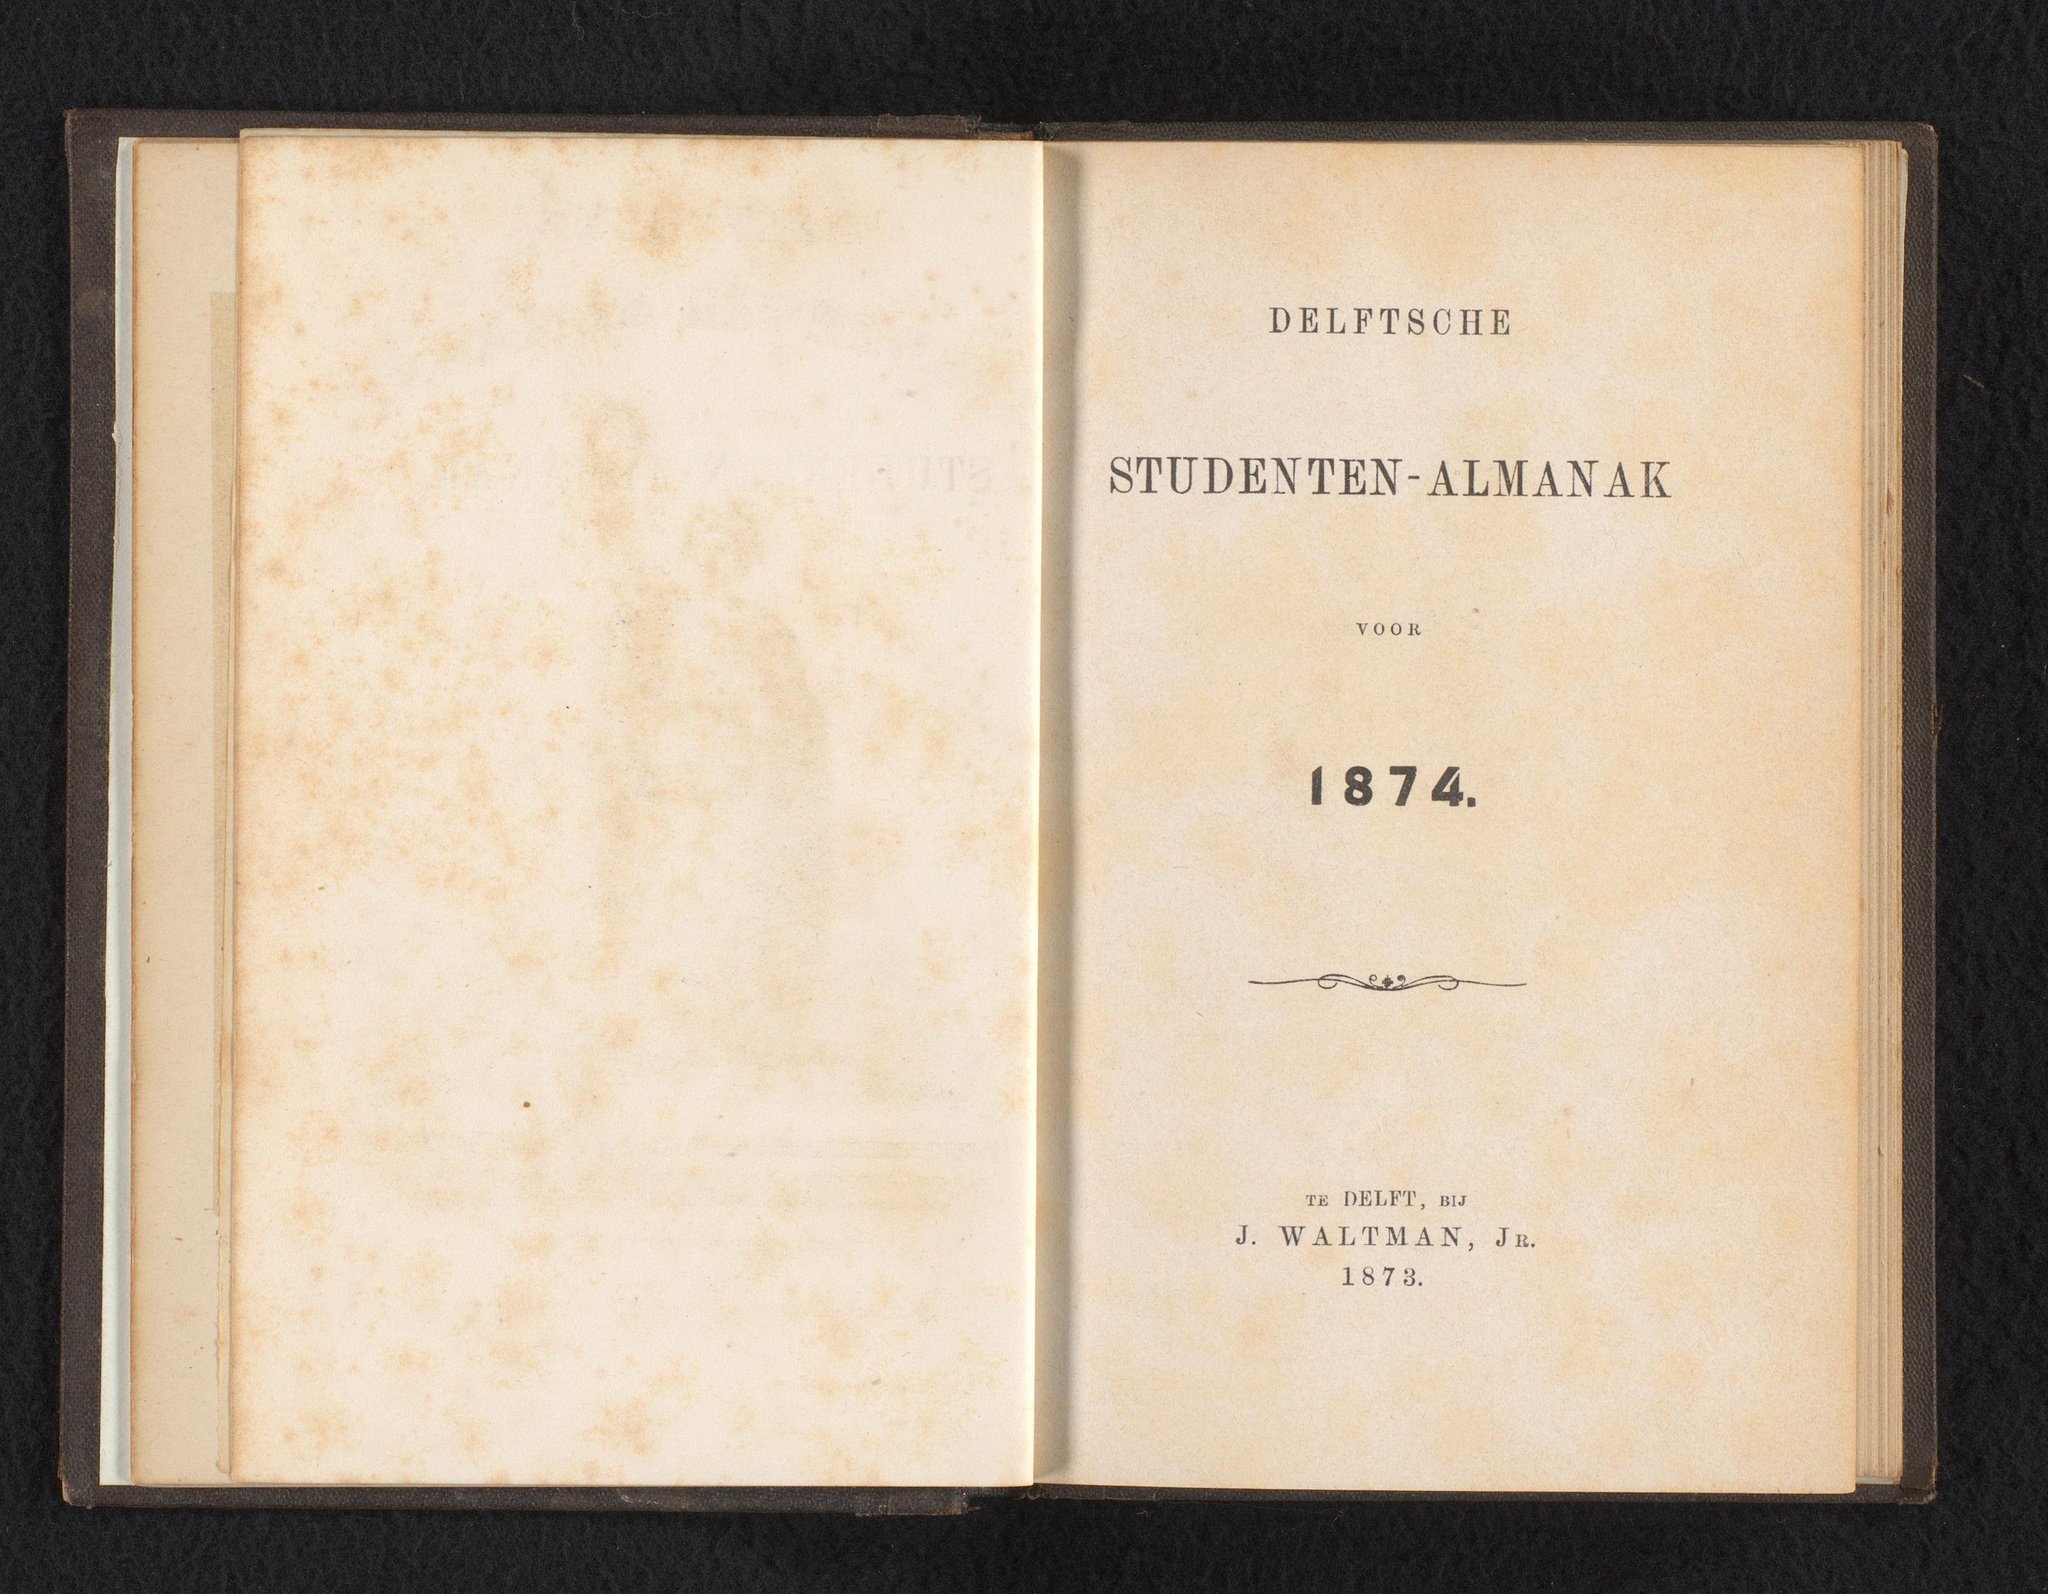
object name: book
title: Delftsche studenten-almanak voor 1874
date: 1873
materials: paper, cardboard, linen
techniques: albumen print, letterpress printing, lithograph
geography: delft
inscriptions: inscription: ‘J.L. Bienfait’